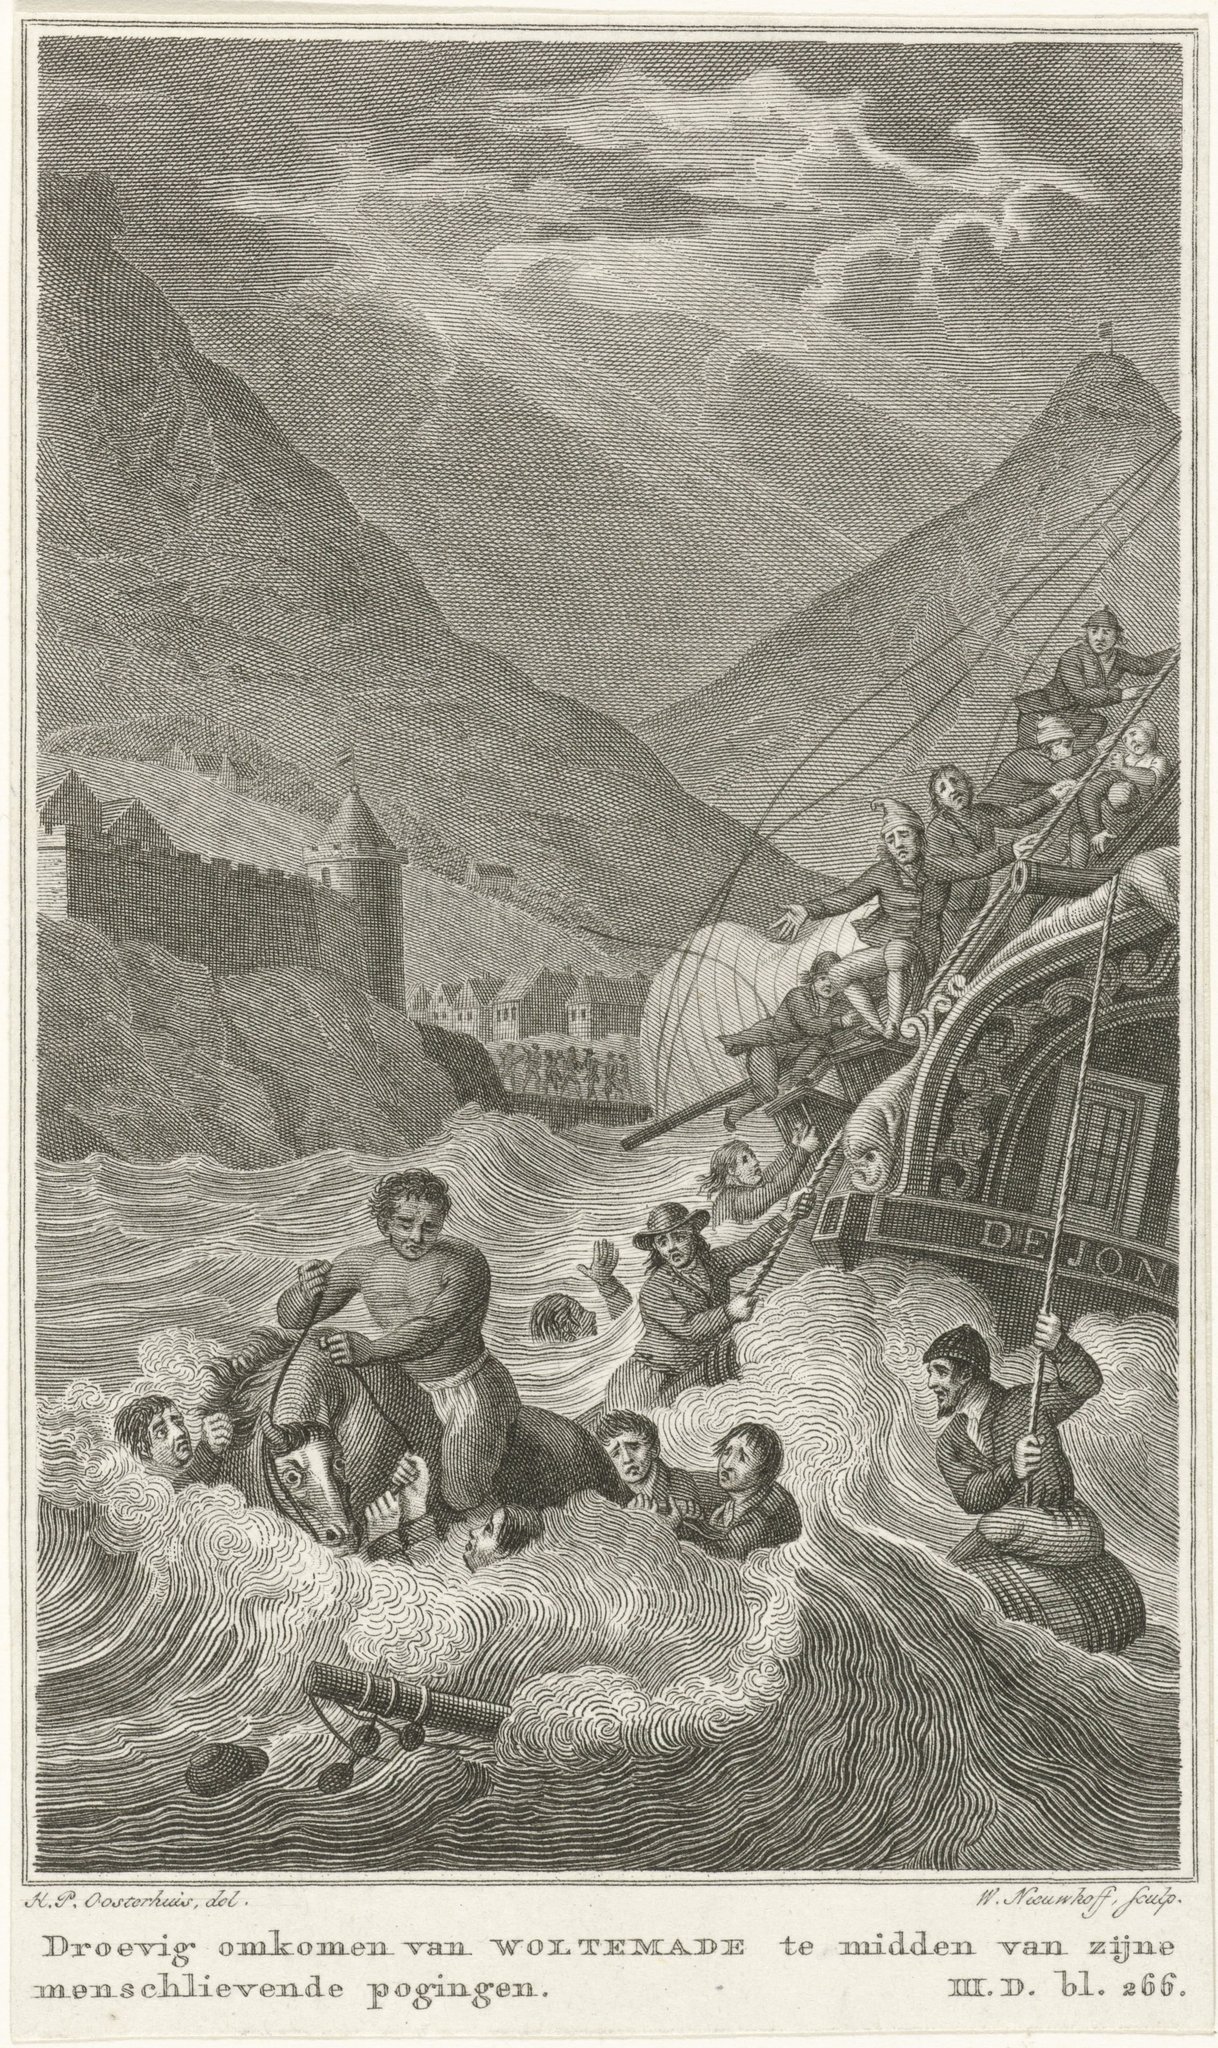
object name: print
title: Droevig omkomen van Woltemade te midden van zijne menschlievende pogingen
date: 1830-1833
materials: paper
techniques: engraving, etching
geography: netherlands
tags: drowning, shipwrecked person, shipwreck, saving a person from drowning, cape of good hope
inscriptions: collector's mark: Lugt 2228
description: Heldendood van de Zuid-Afrikaanse veeopzichter Wolraad Woltemade tijdens het redden met zijn paaard van veertien schipbreukelingen uit het wrak van het schip De Jonge Thomas in de branding voor de kust van Kaap de Goede Hoop, 1 juni 1773. Gemerkt rechtsonder: III. D. bl. 266.